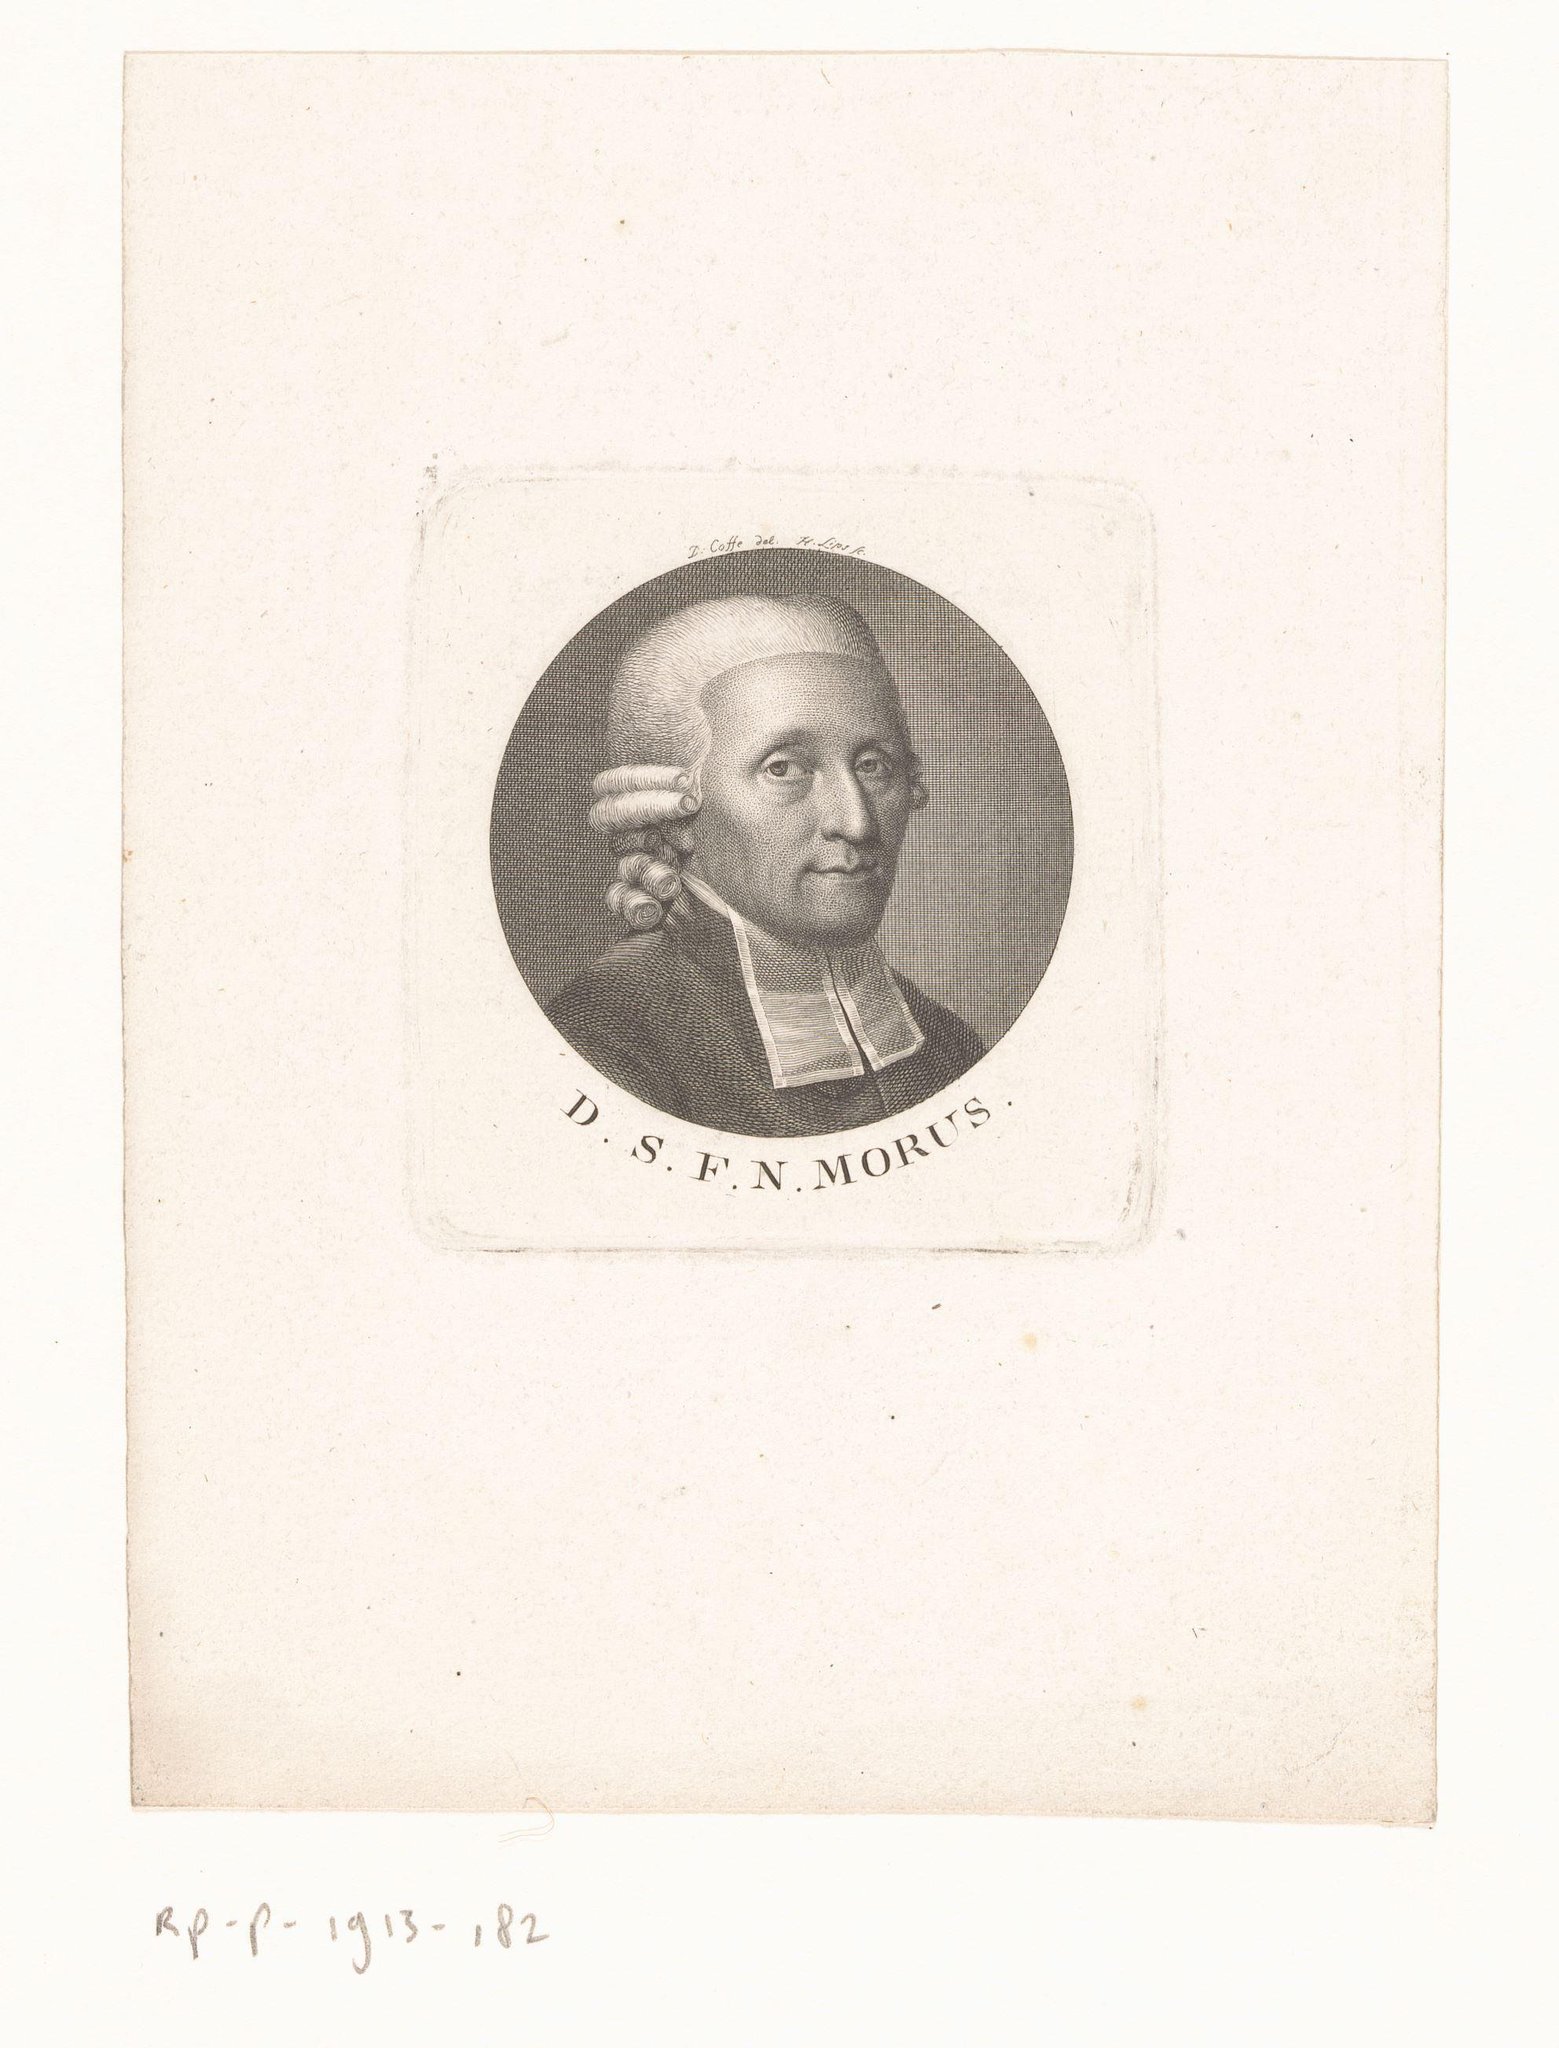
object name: print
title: Portret van Samuel Friedrich Nathanael Morus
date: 1792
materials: paper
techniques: engraving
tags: theologian, historical persons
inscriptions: collector's mark: Lugt 2228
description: Prent ook gebruikt in: Allgemeines Magazin für Prediger nach den Bedürfnissen unsrer Zeit. Leipzig: Siegfried Lebrecht Crusius, 1792. Dl. 6.2.